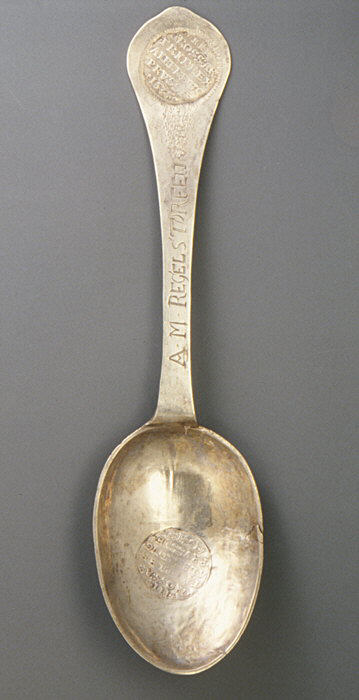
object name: spoon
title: Wavy-end spoon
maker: georg friedrich scholtze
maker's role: maker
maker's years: 1737-1752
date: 1701-1733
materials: silver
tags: men,profiles